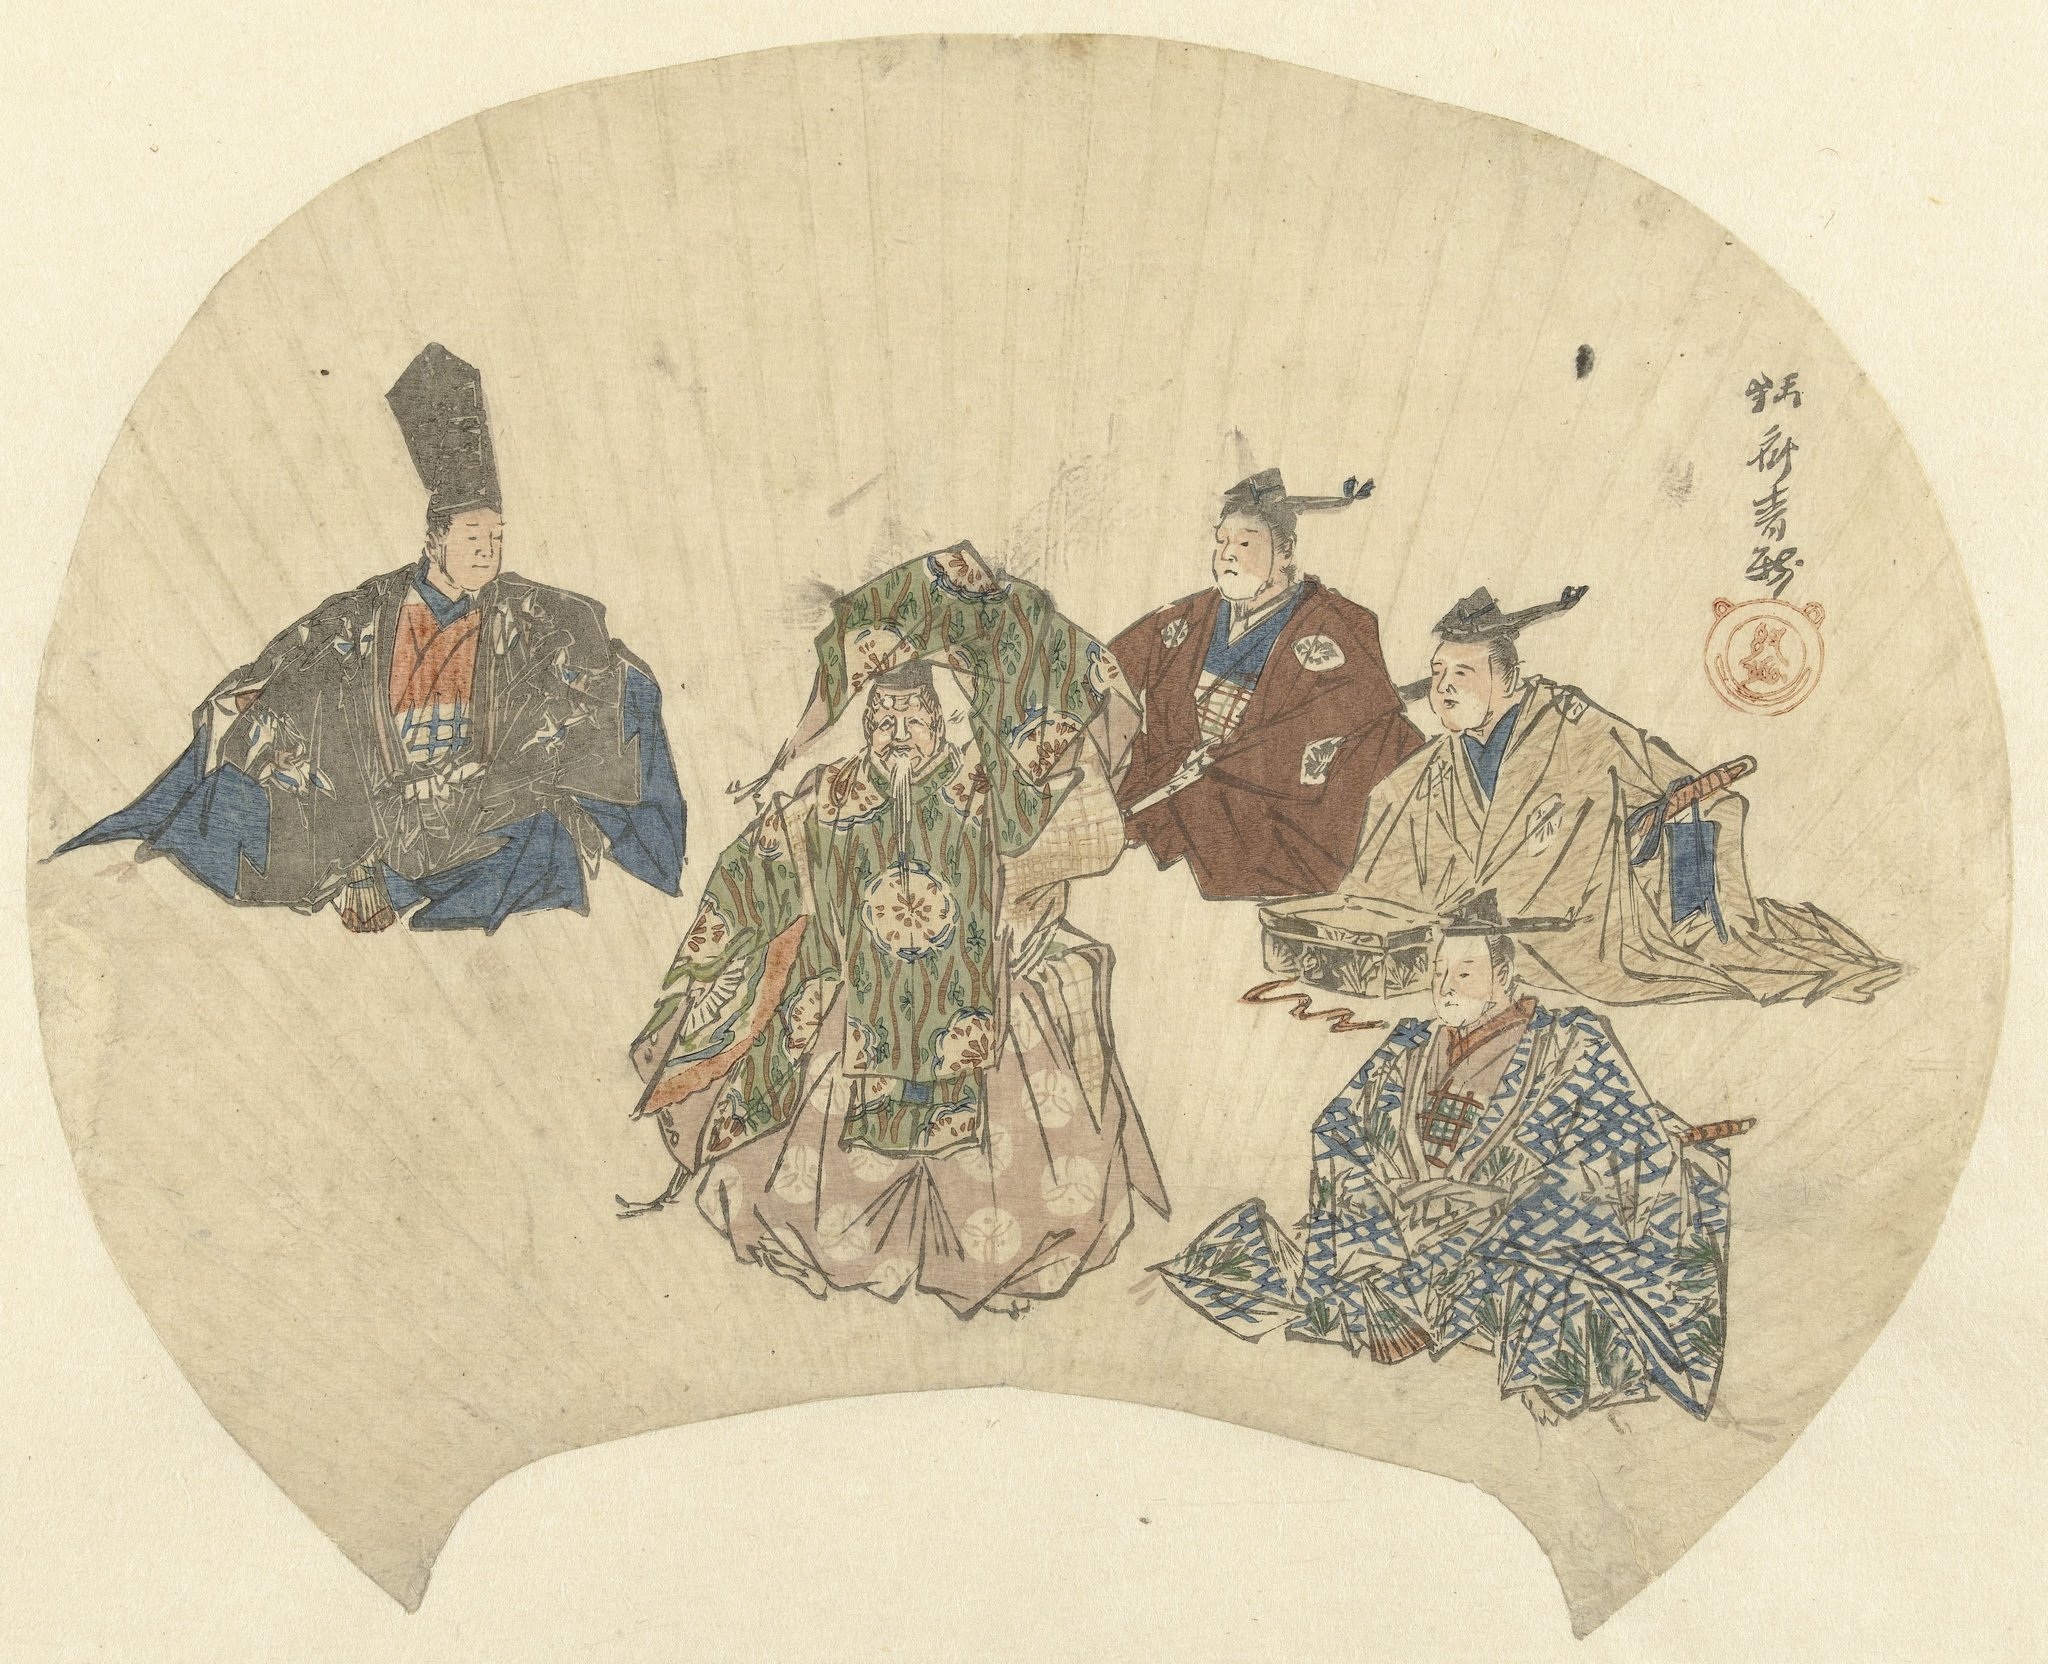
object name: uchiwa e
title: Scene uit het toneelstuk Okina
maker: kawanabe kyôsai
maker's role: draughtsman, print maker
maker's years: 1831-1889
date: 1865-1870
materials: paper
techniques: woodcut, nishiki e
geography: japan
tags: fan, actor (on the stage)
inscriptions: collector's mark: Lugt 2228